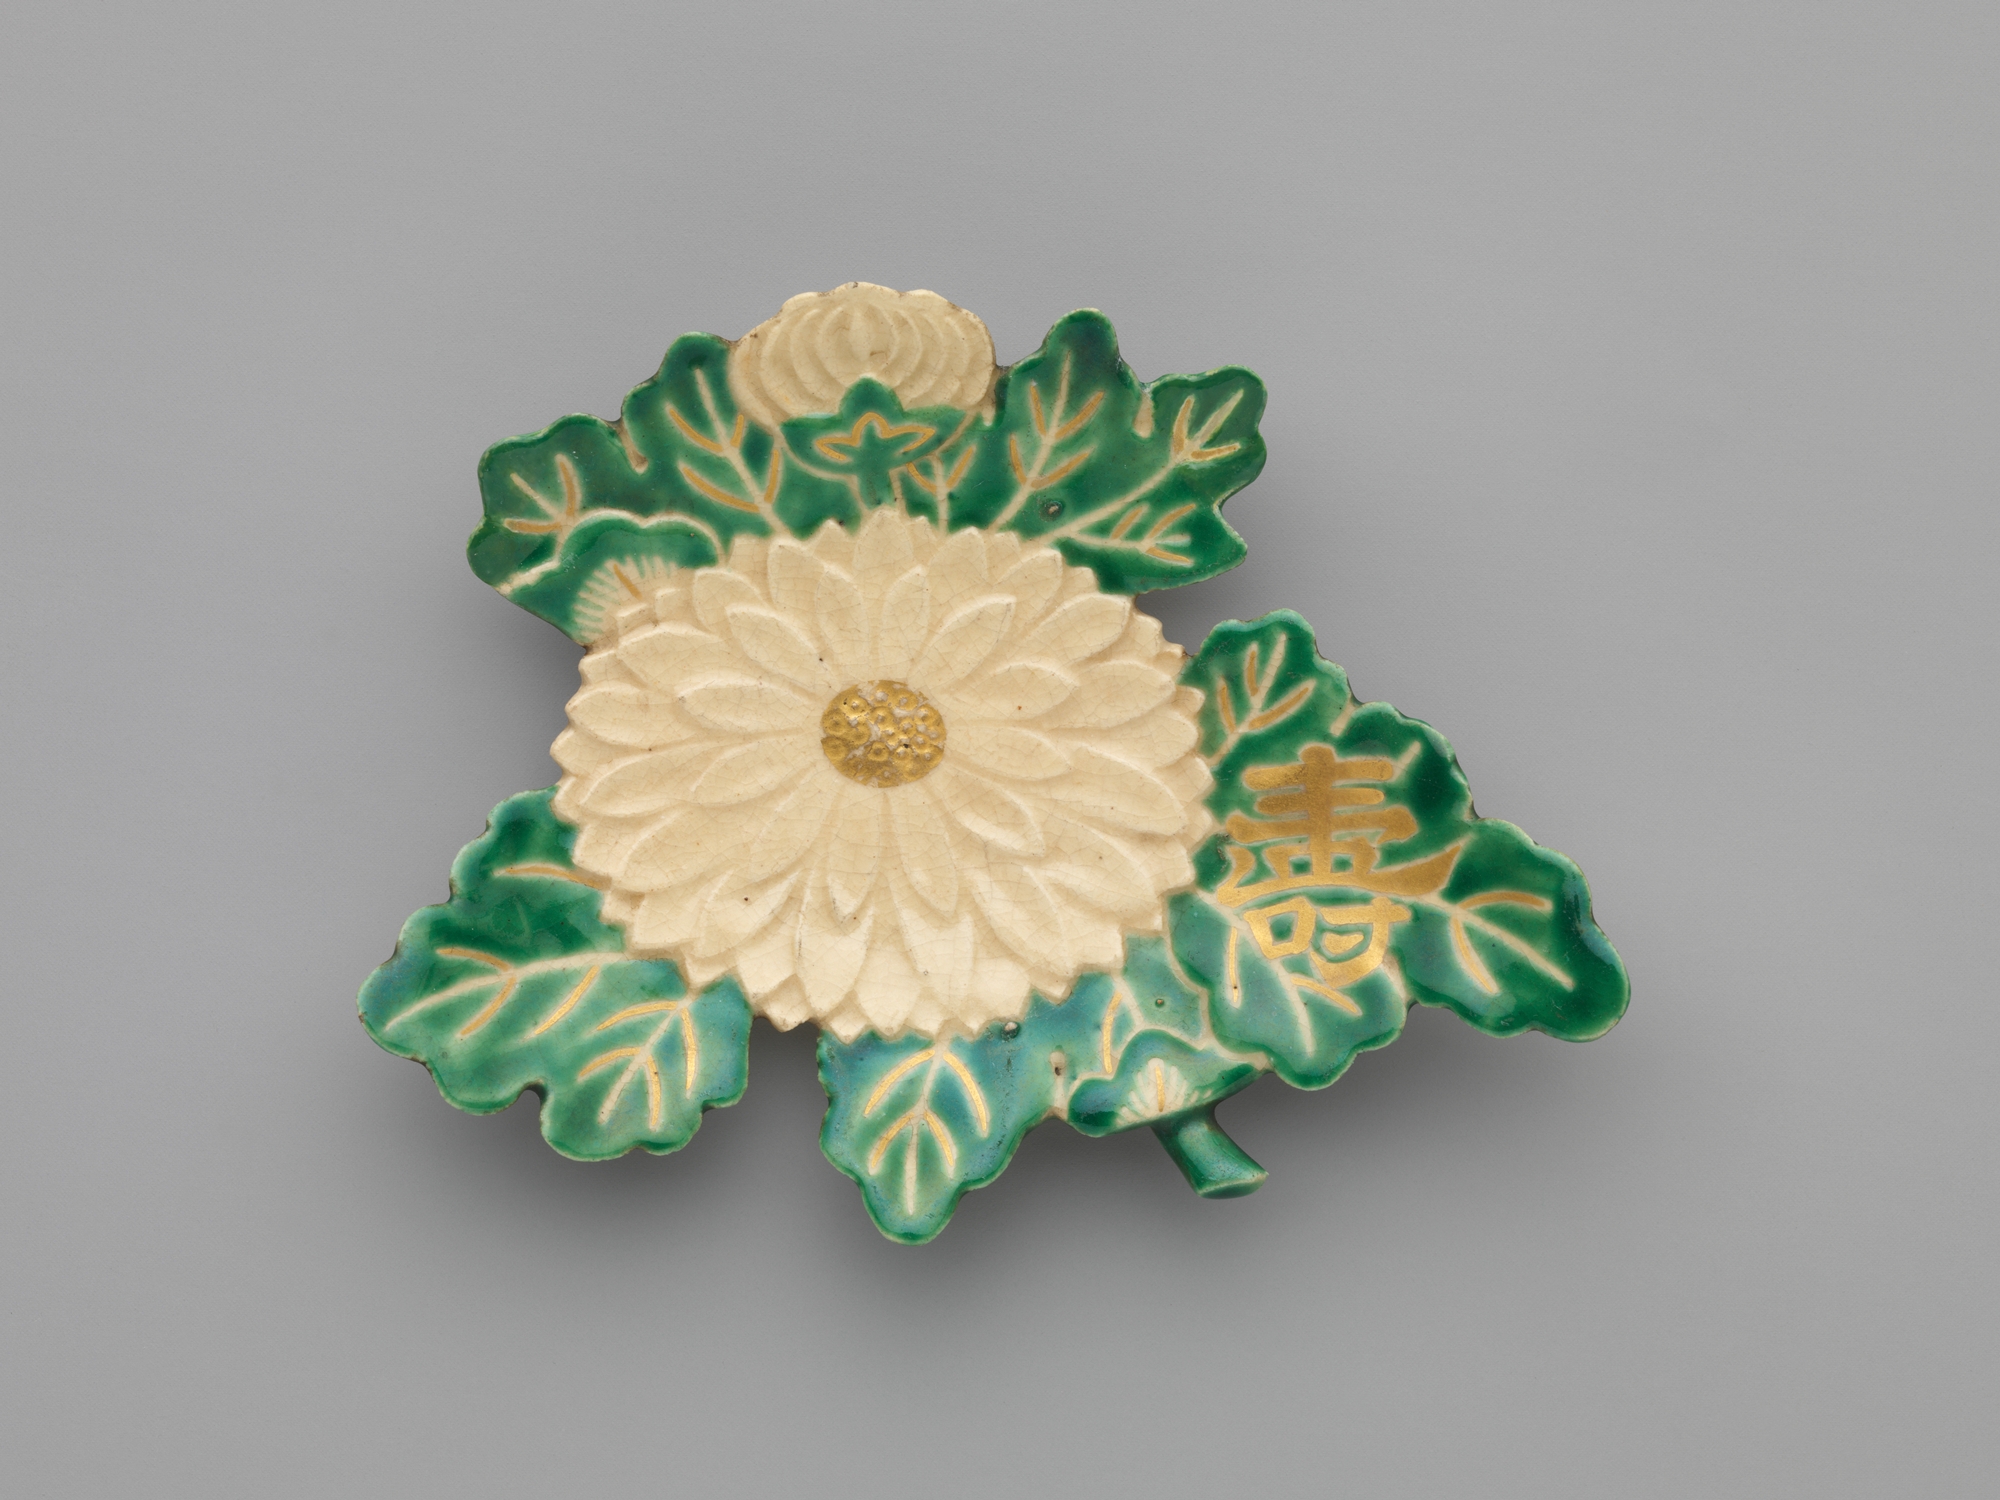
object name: dish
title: Kenzan-style Dish in the Shape of Chrysanthemum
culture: japanese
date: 1801-1833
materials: enamel, stoneware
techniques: overglaze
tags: leaves